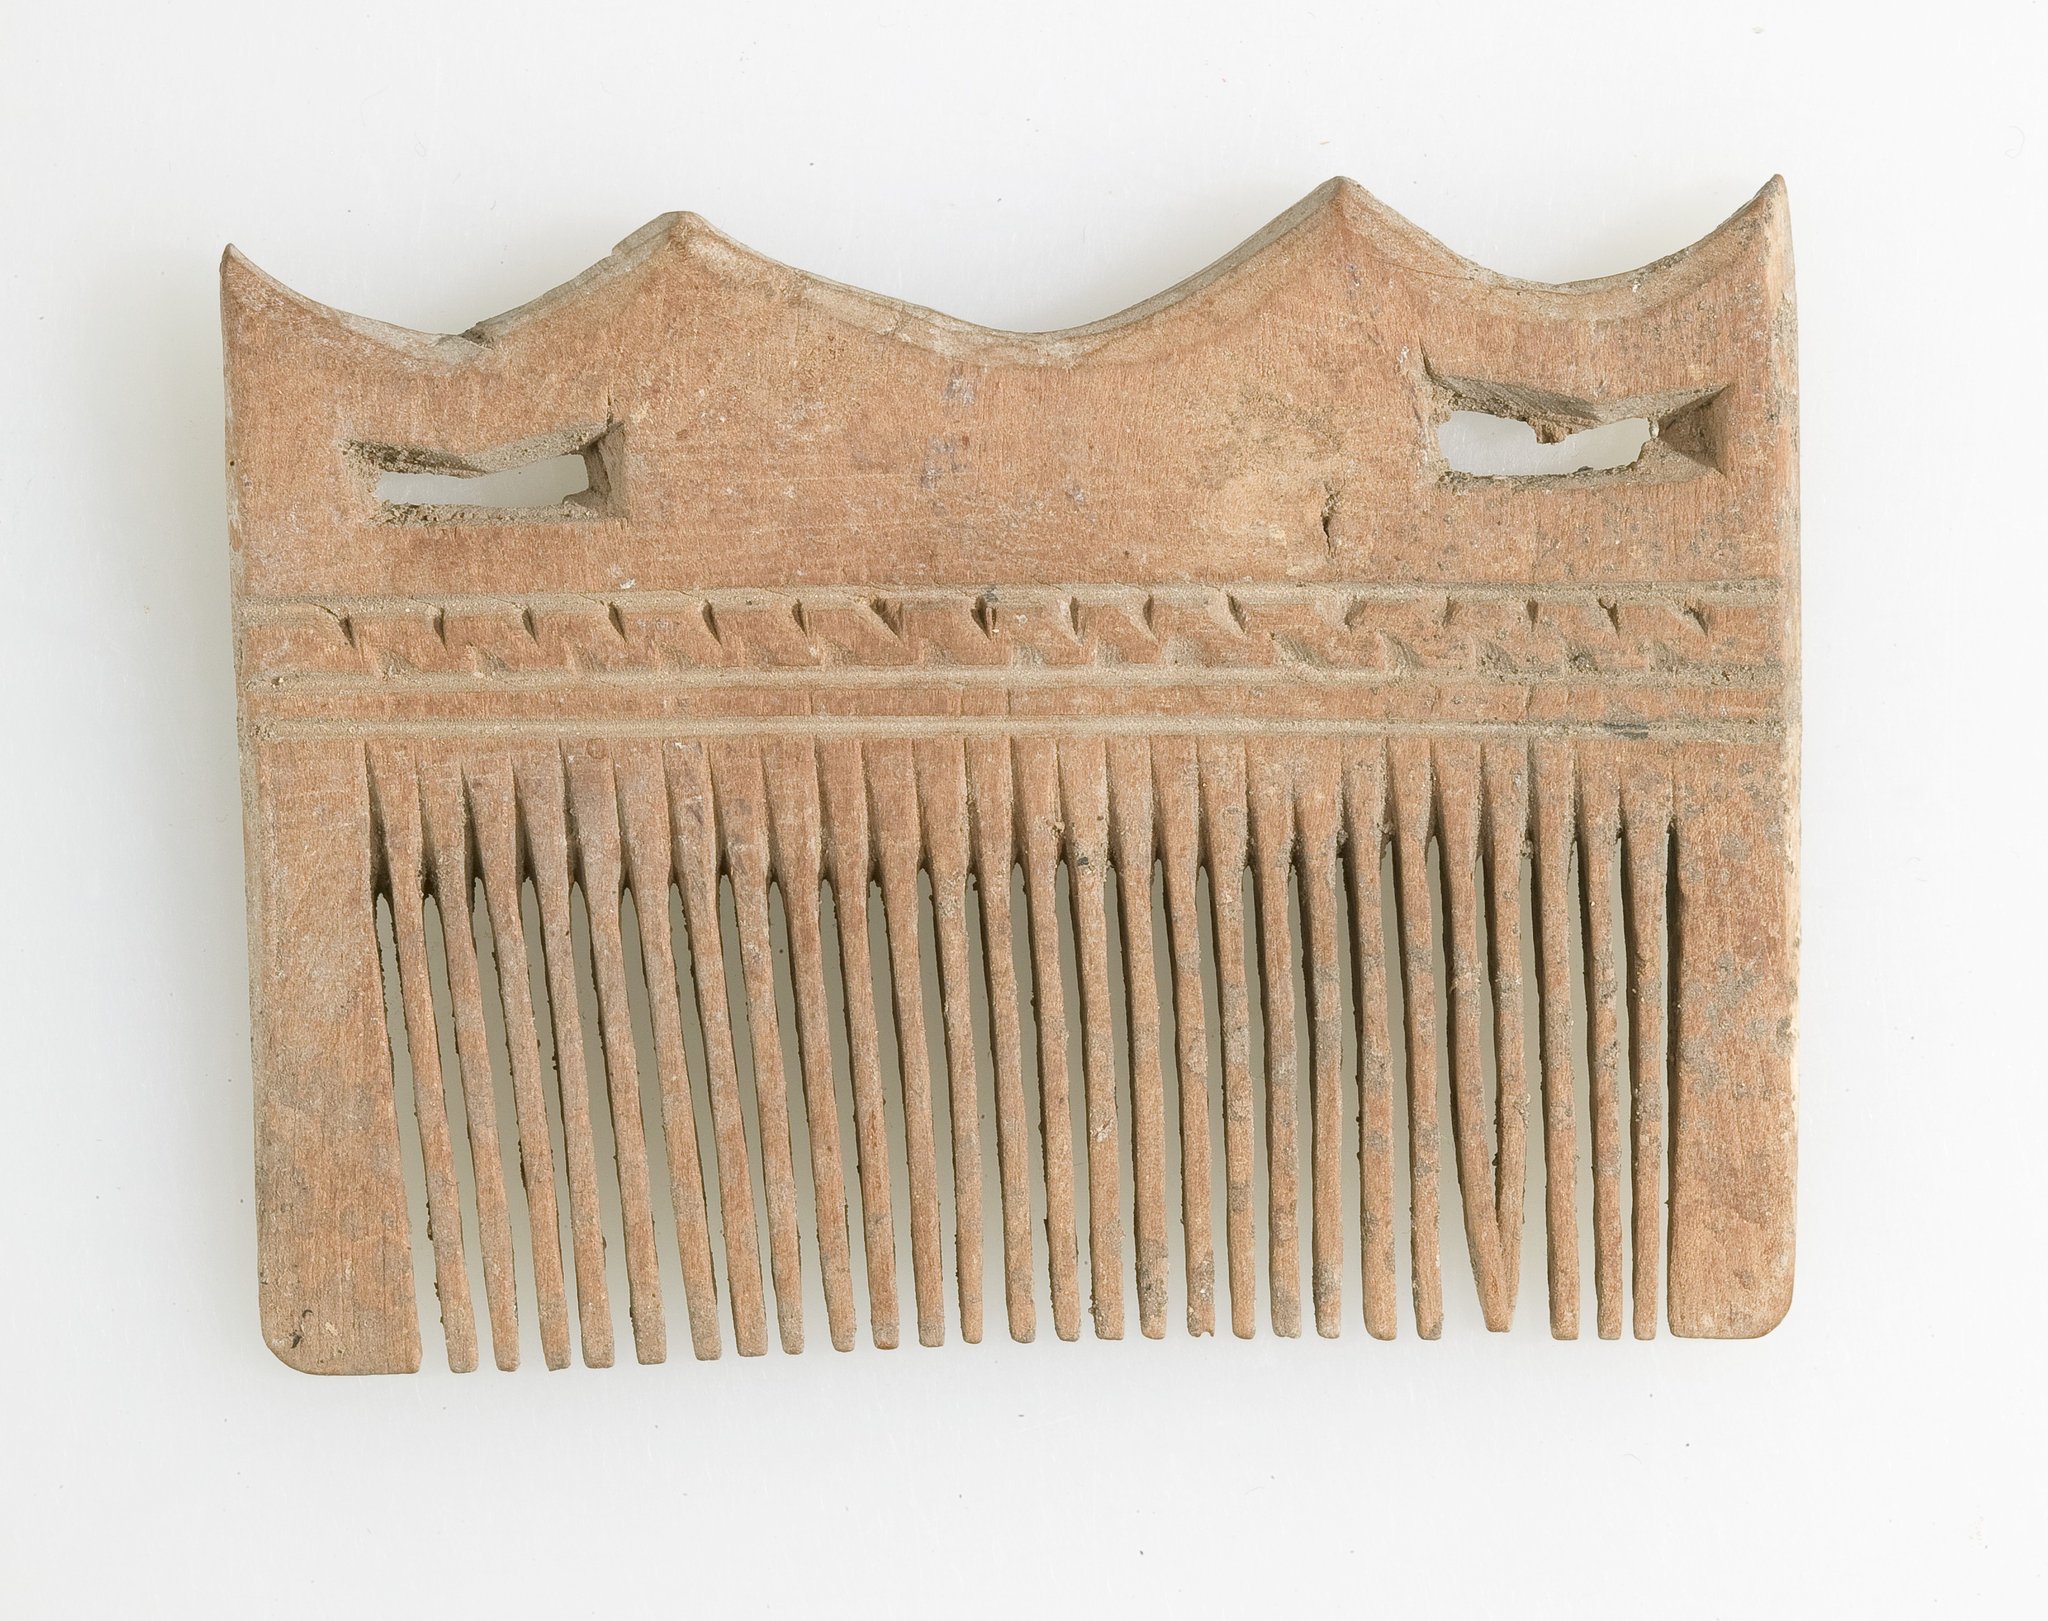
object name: comb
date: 1981-1640 BCE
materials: wood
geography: egypt